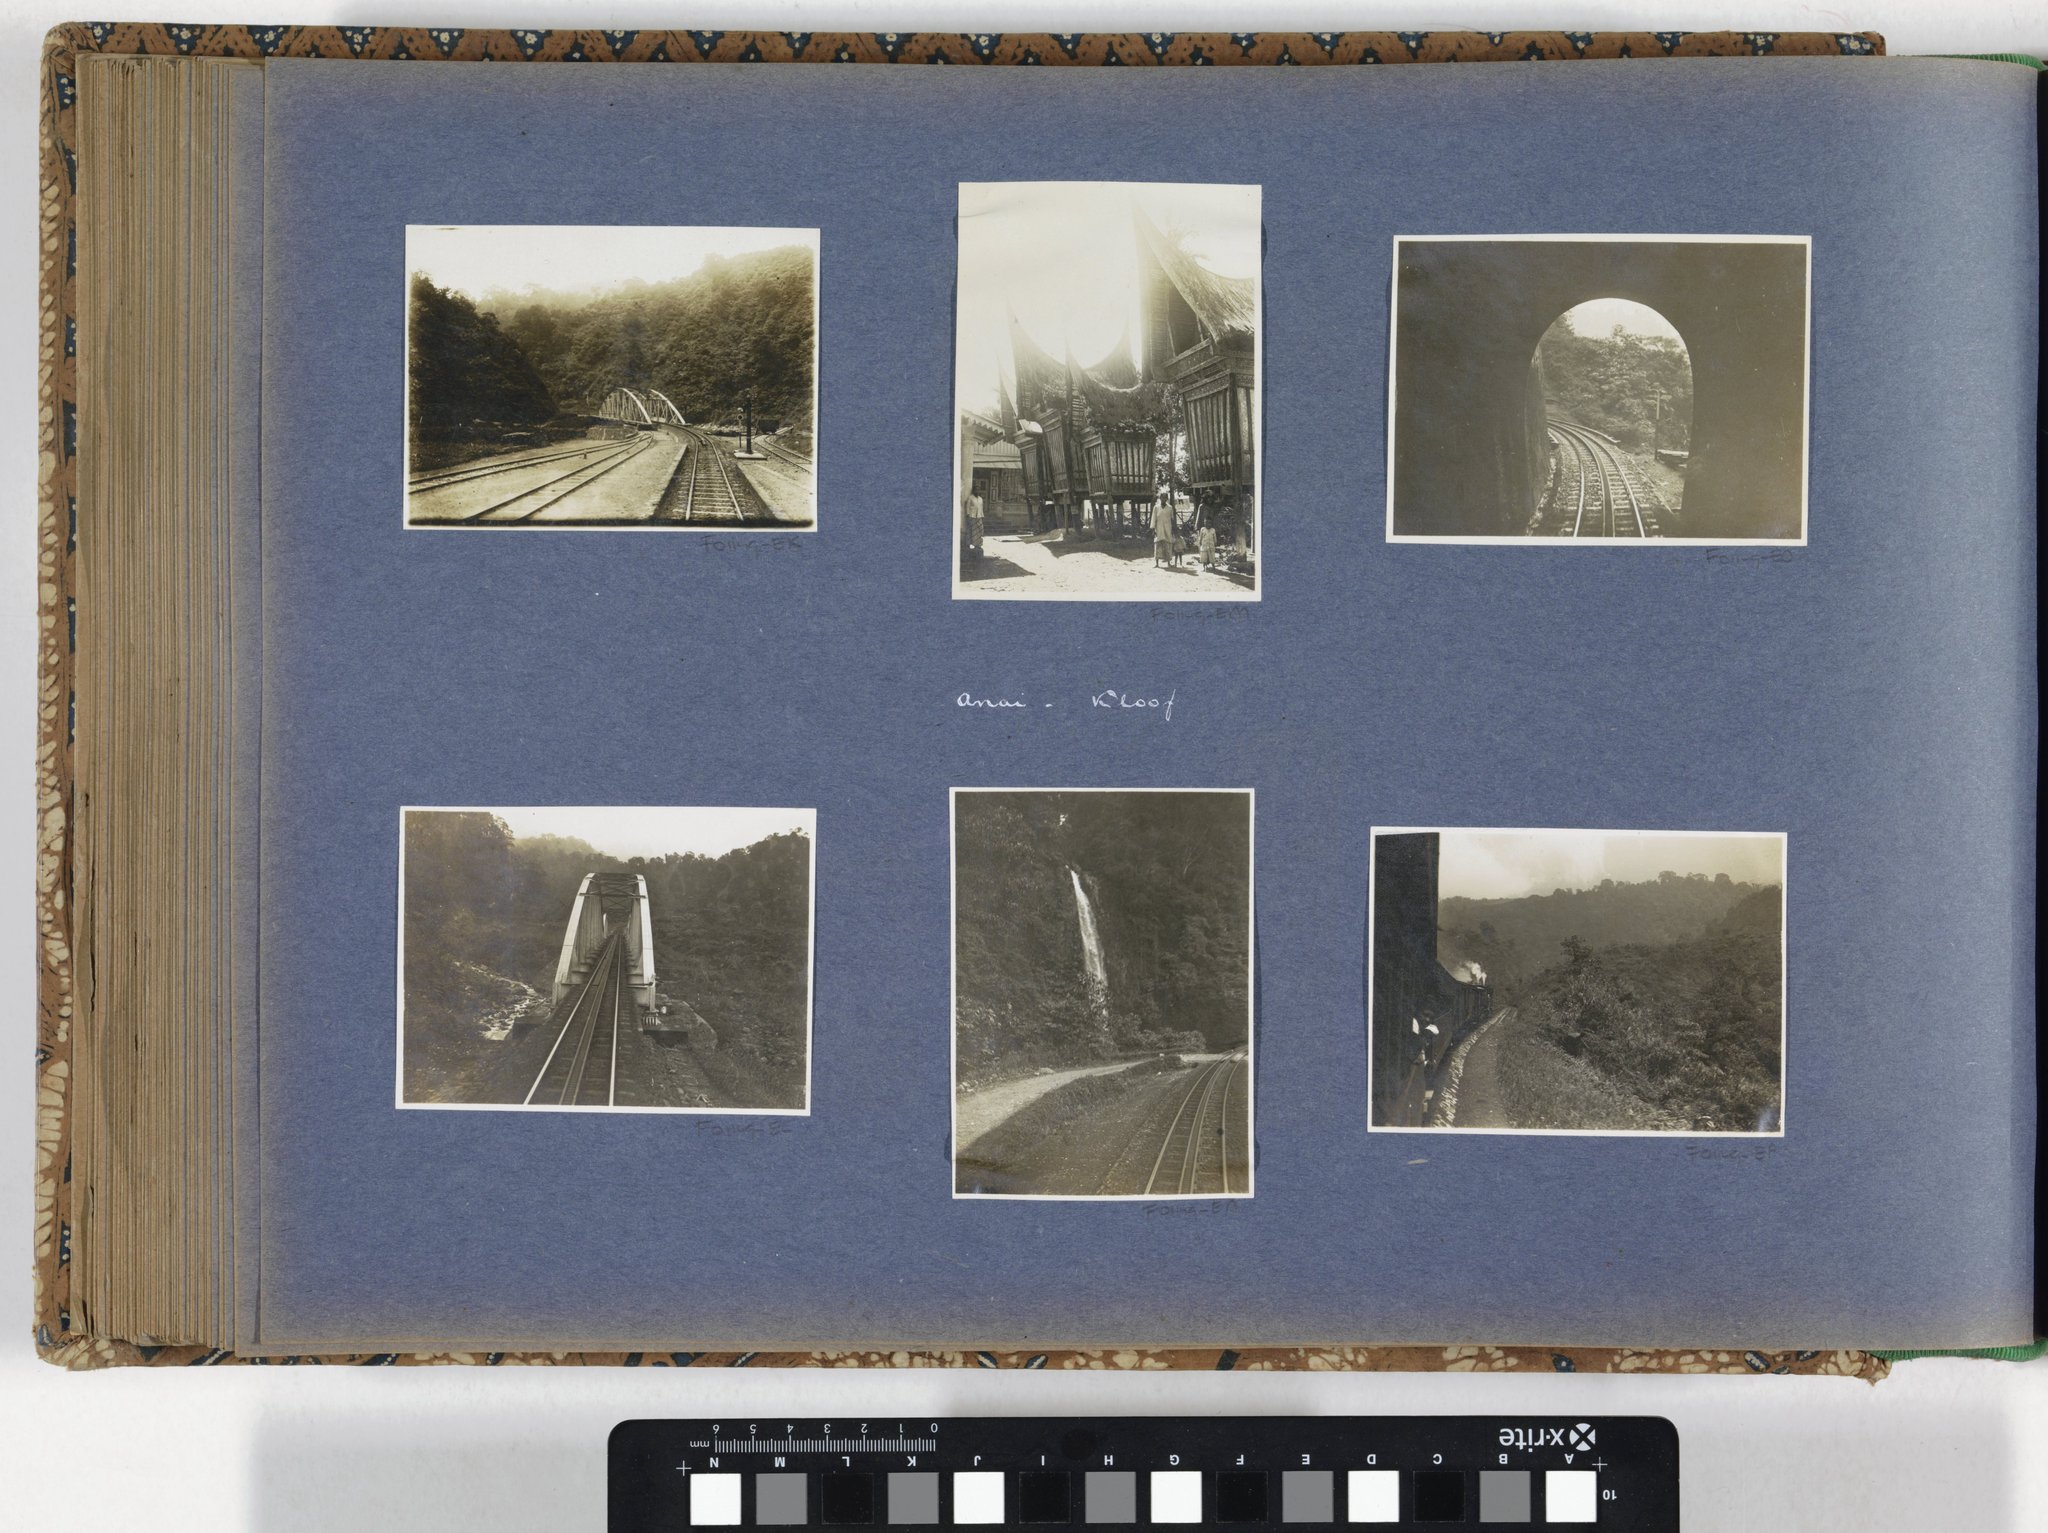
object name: photograph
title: Anaikloof gezien langs een rijdende trein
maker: Anonymous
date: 1900-1920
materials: paper, photographic support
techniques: gelatin silver print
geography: sumatra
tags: ravine, chasm, abyss, canyon, railway, train, sumatra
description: Onderdeel van reisalbum met foto's van bedrijvigheid en bezienswaardigheden op Sumatra en Java en van de reis naar en van Nederlands-Indië.